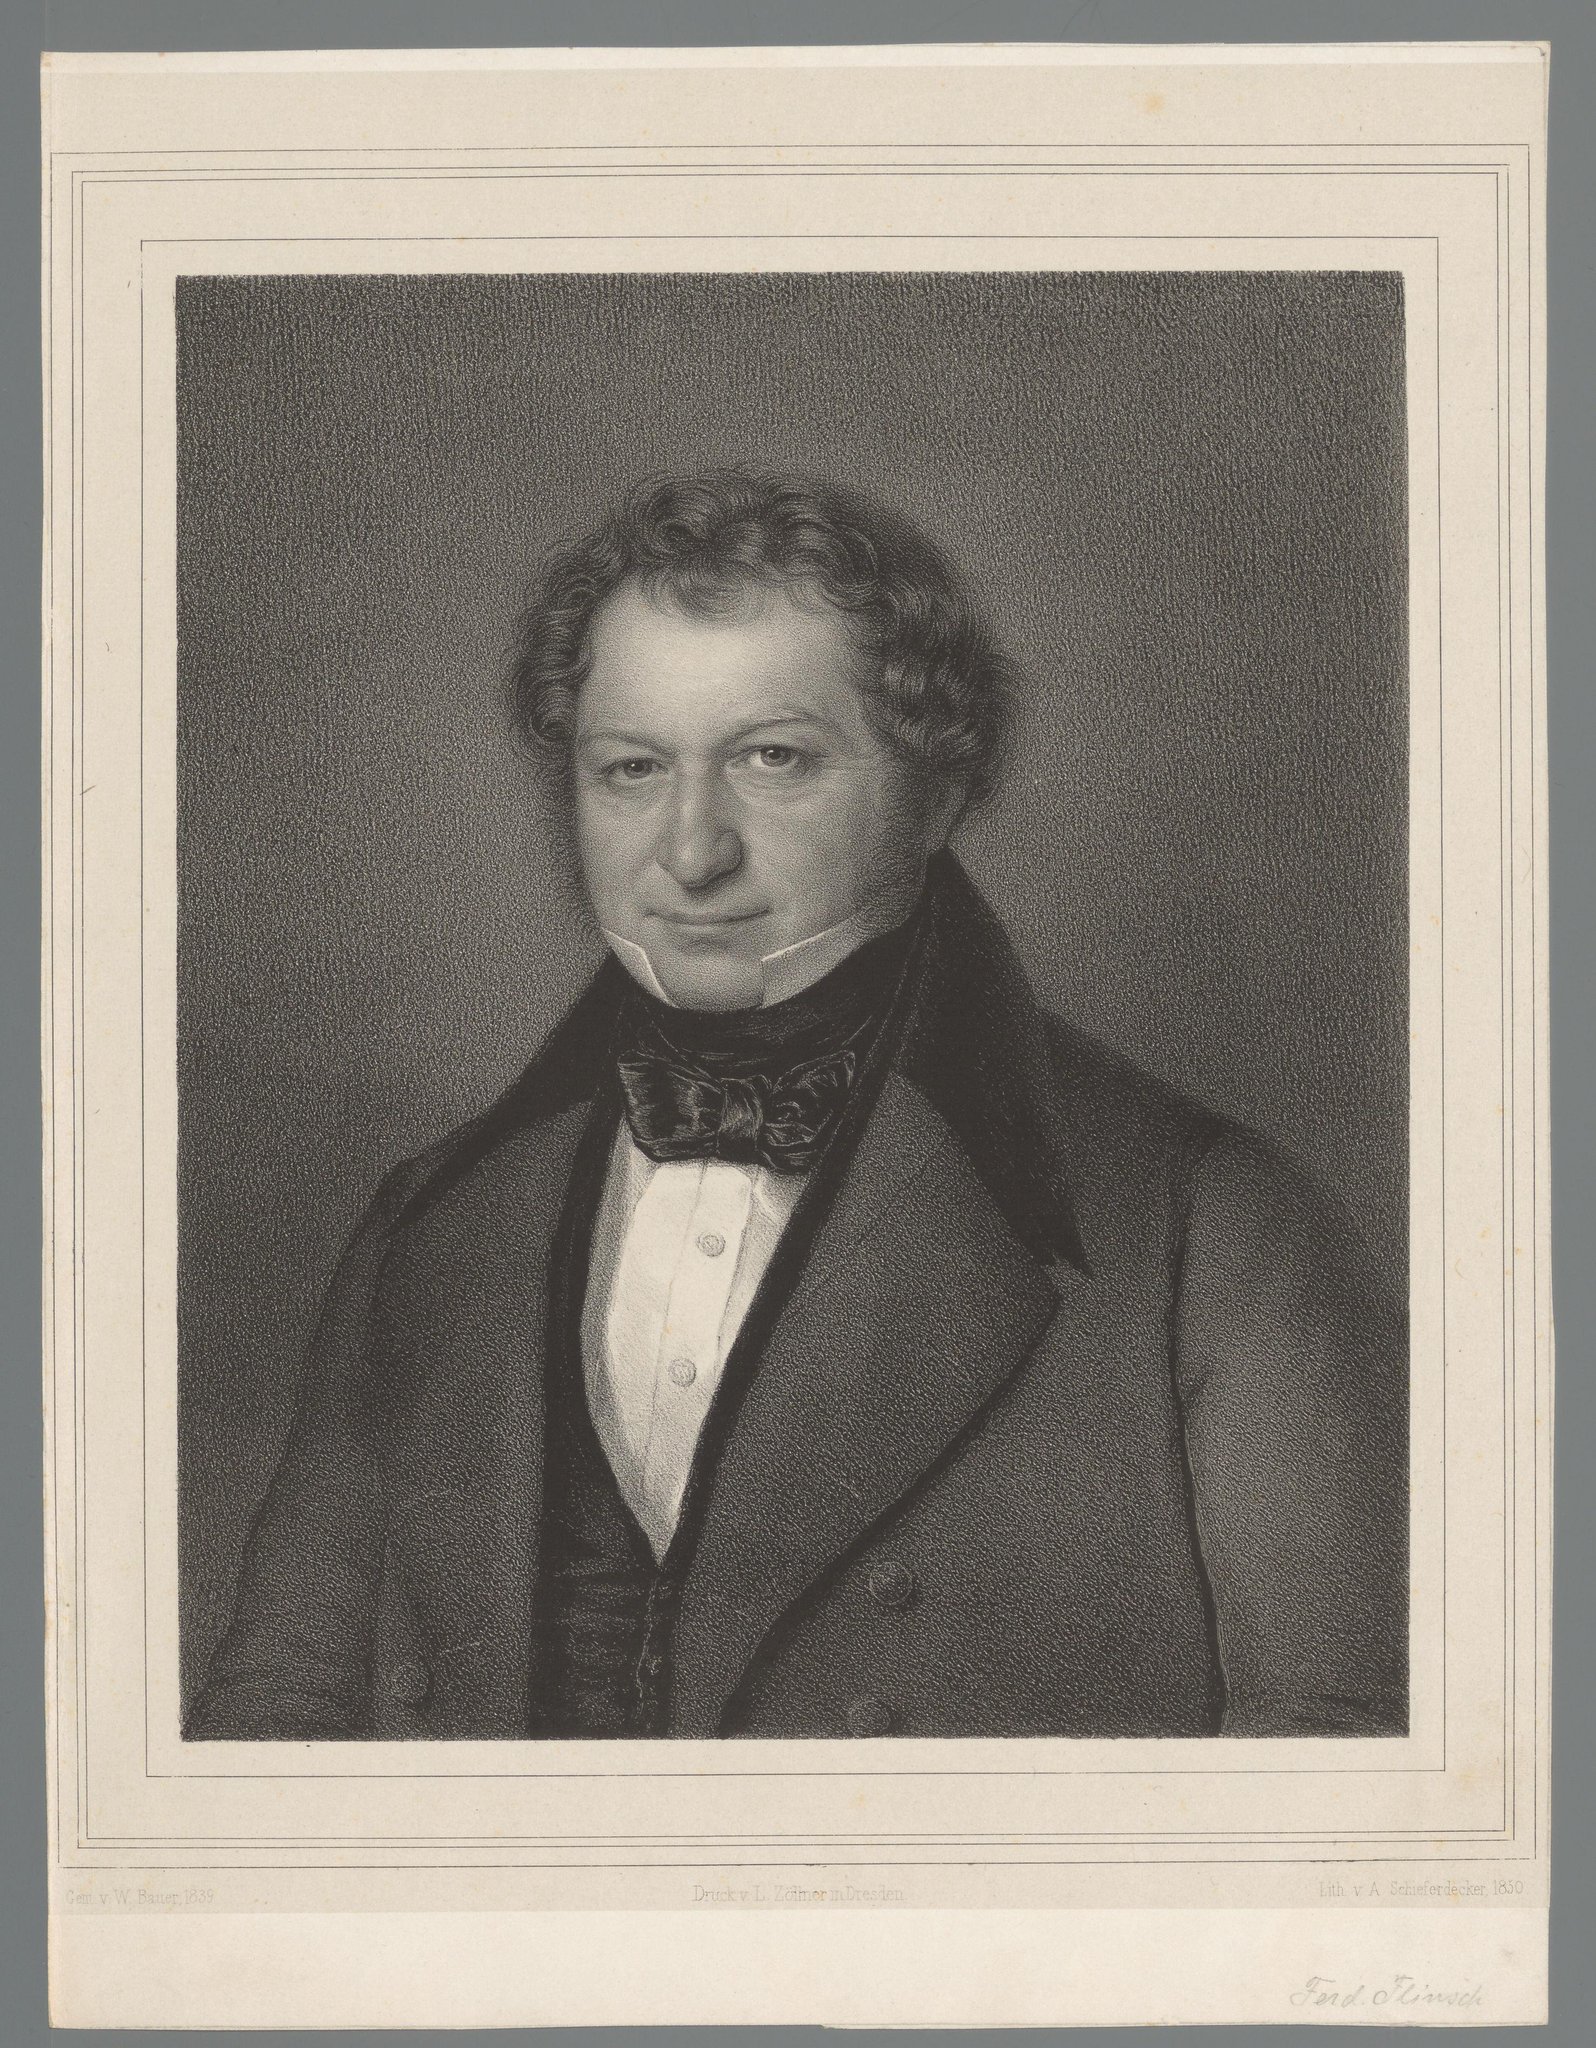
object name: print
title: Portret van Ferdinand Traugott Flinsch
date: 1850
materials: paper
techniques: lithograph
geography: dresden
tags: historical persons, crafts and industries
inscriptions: collector's mark: Lugt 2228